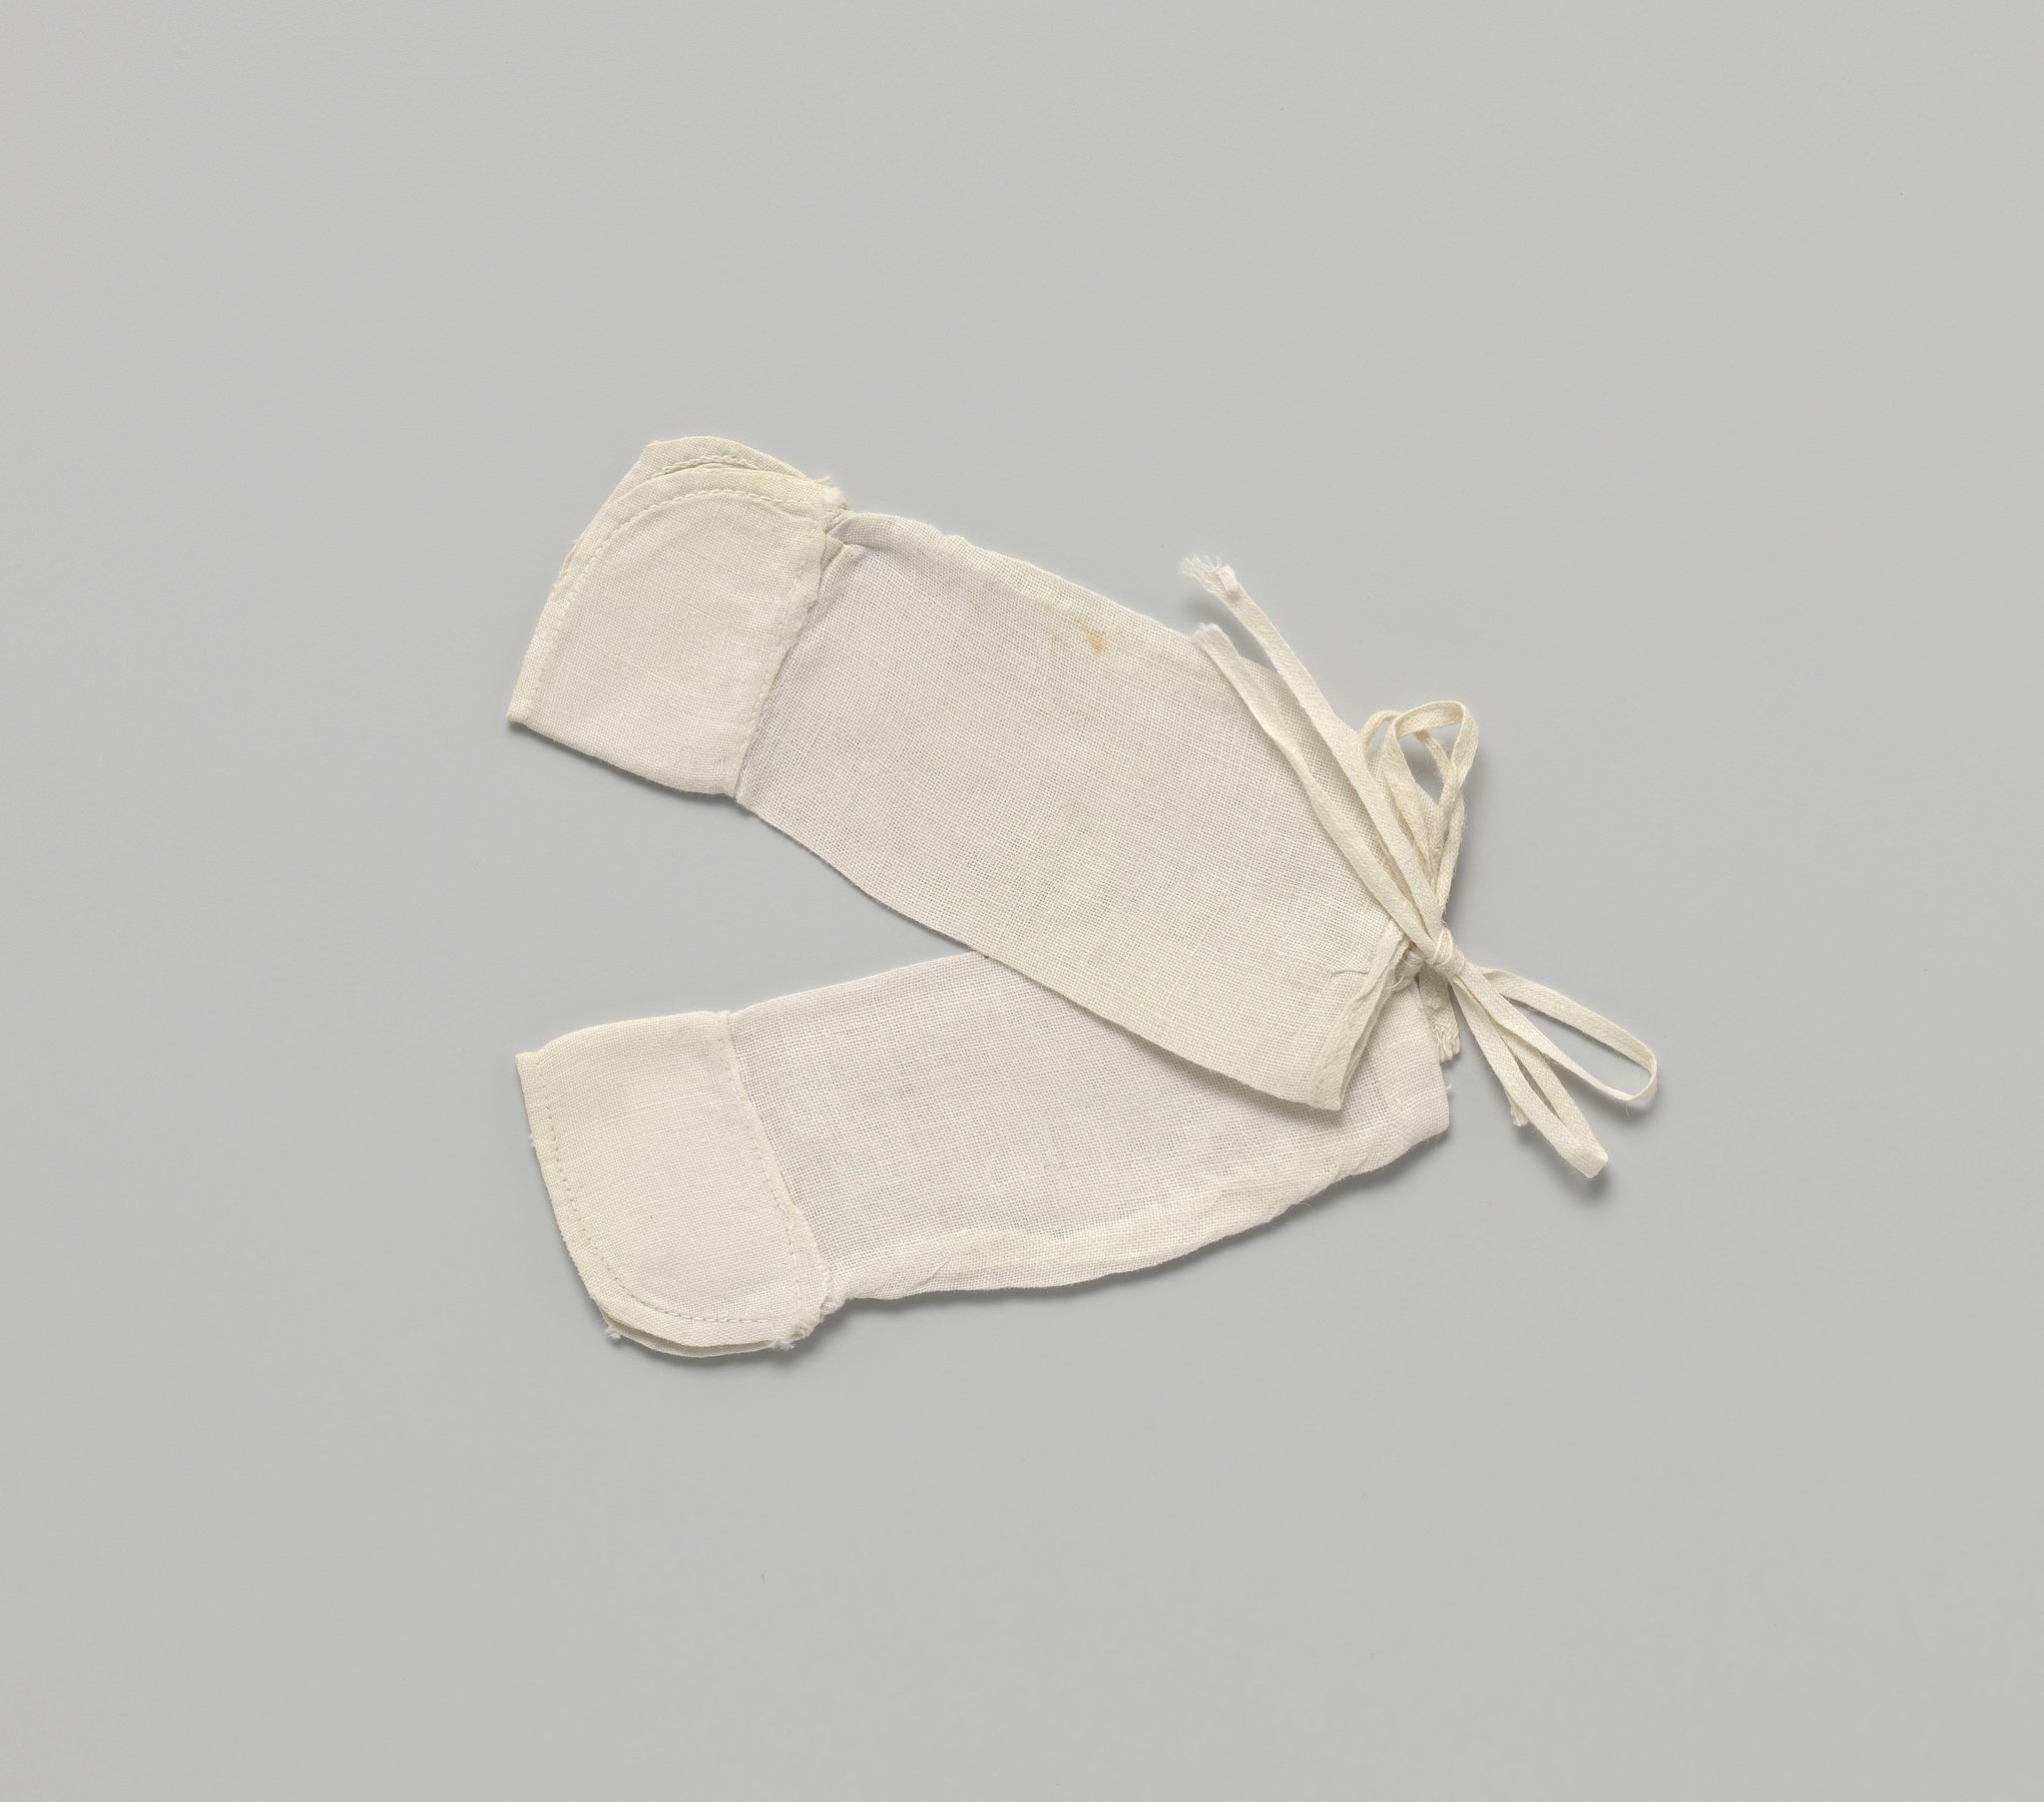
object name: doll's clothing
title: Paar mouwen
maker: Anonymous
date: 1850-1920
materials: textile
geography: netherlands